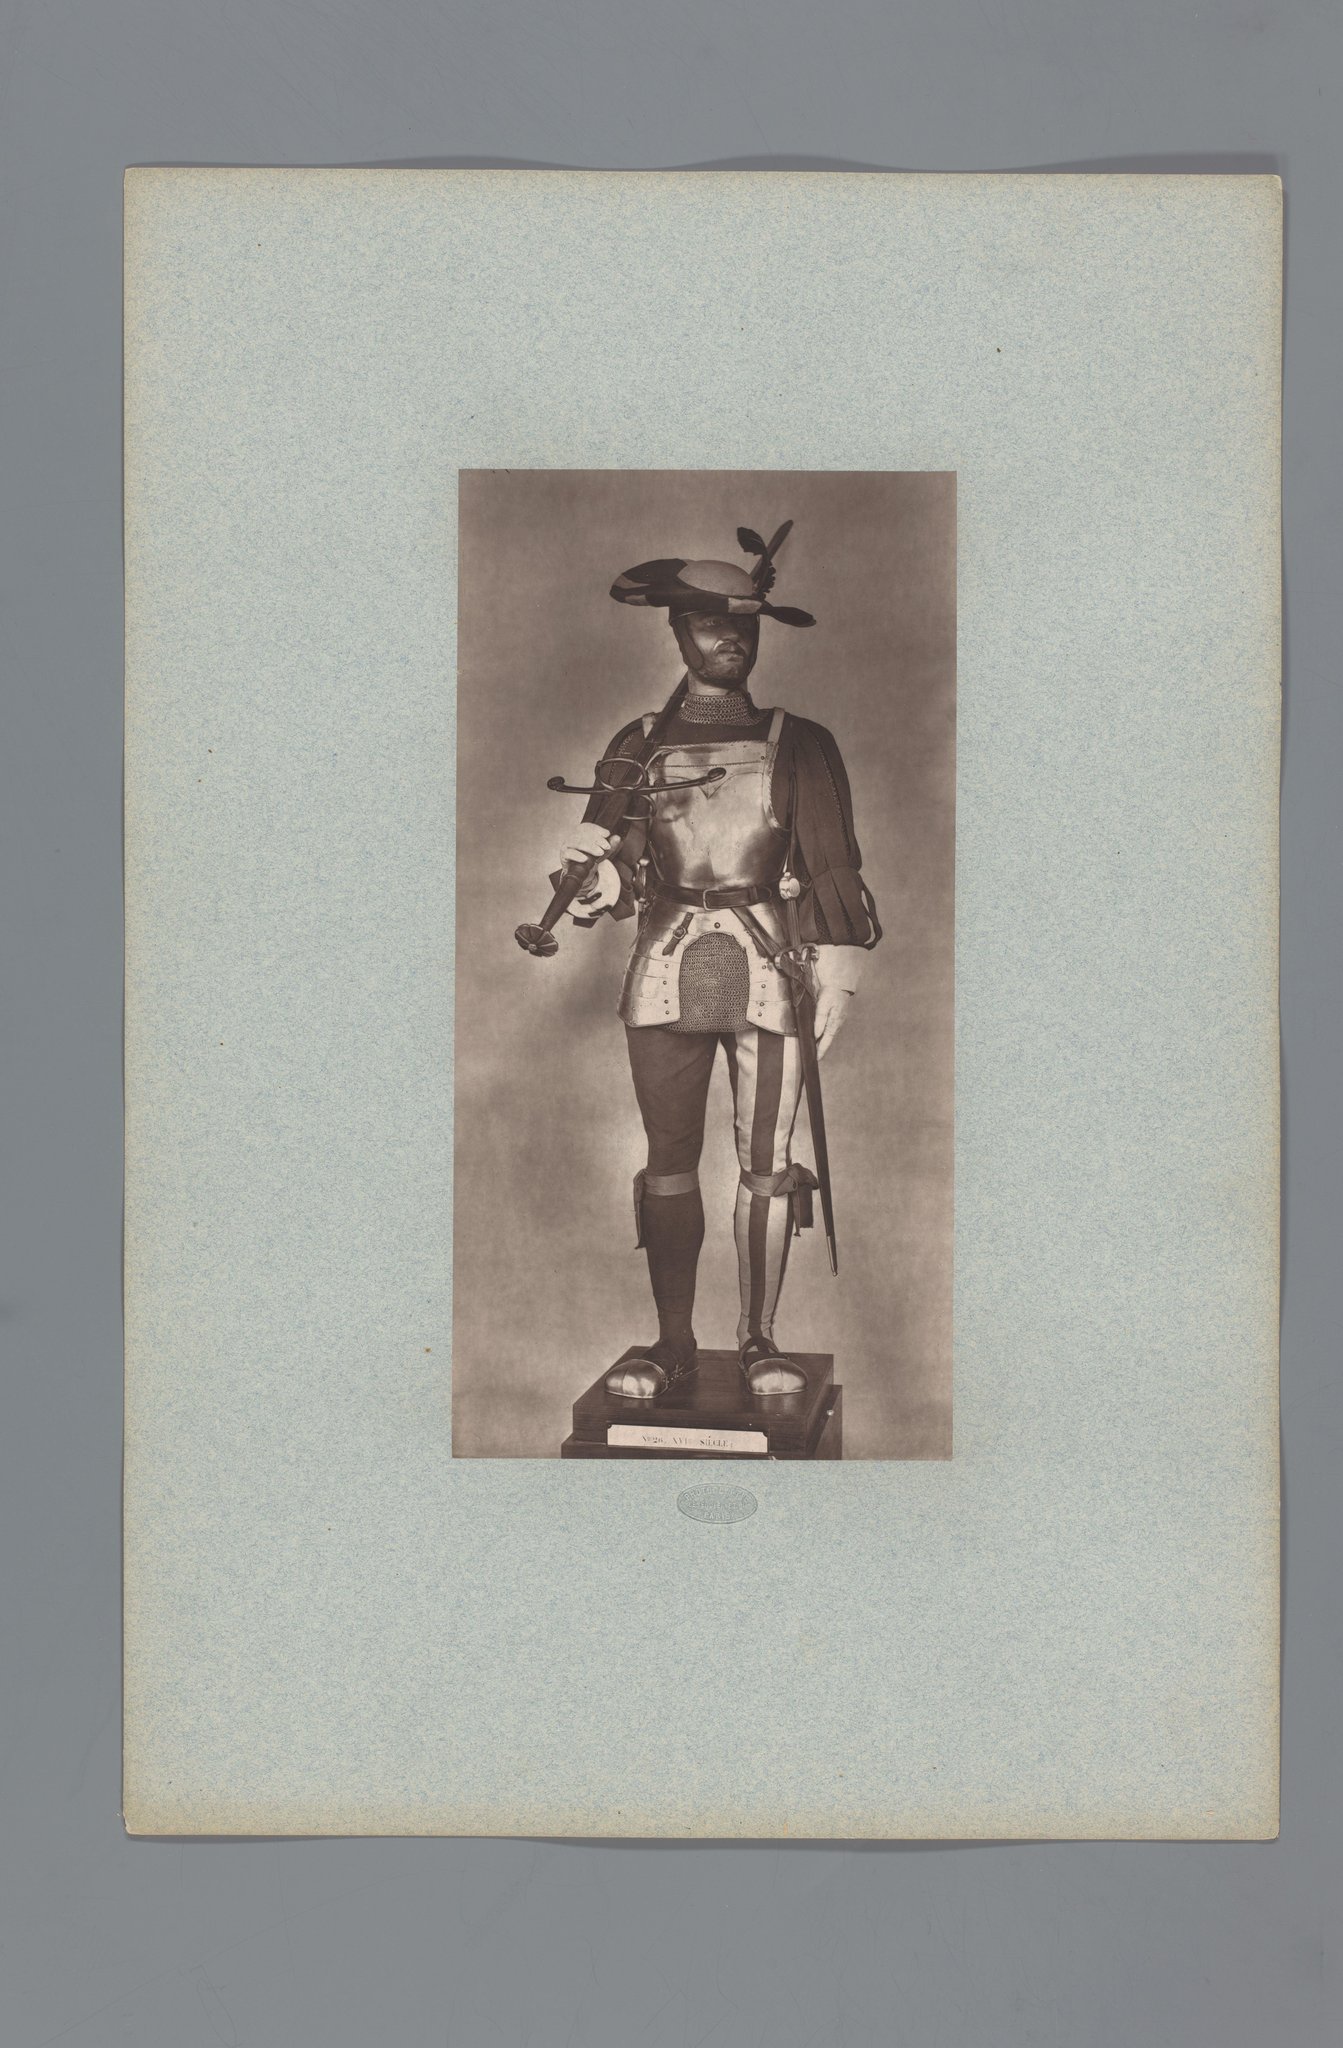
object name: photomechanical print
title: 16de-eeuws harnas met twee zwaarden uit het leger van Frans I van Frankrijk, uit de collectie van het Musée d'Artillerie in Parijs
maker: Anonymous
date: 1877-1882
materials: paper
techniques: woodburytype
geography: paris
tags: armour, hacking and thrusting weapons: sword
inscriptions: check stamp: ‘PHOTOGLYPTIE/ LEMERCIER ET Cie/ PARIS’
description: Deze prent maakt deel uit van een omslag met 36 prenten, een titelblad en een lijst van afbeeldingen.